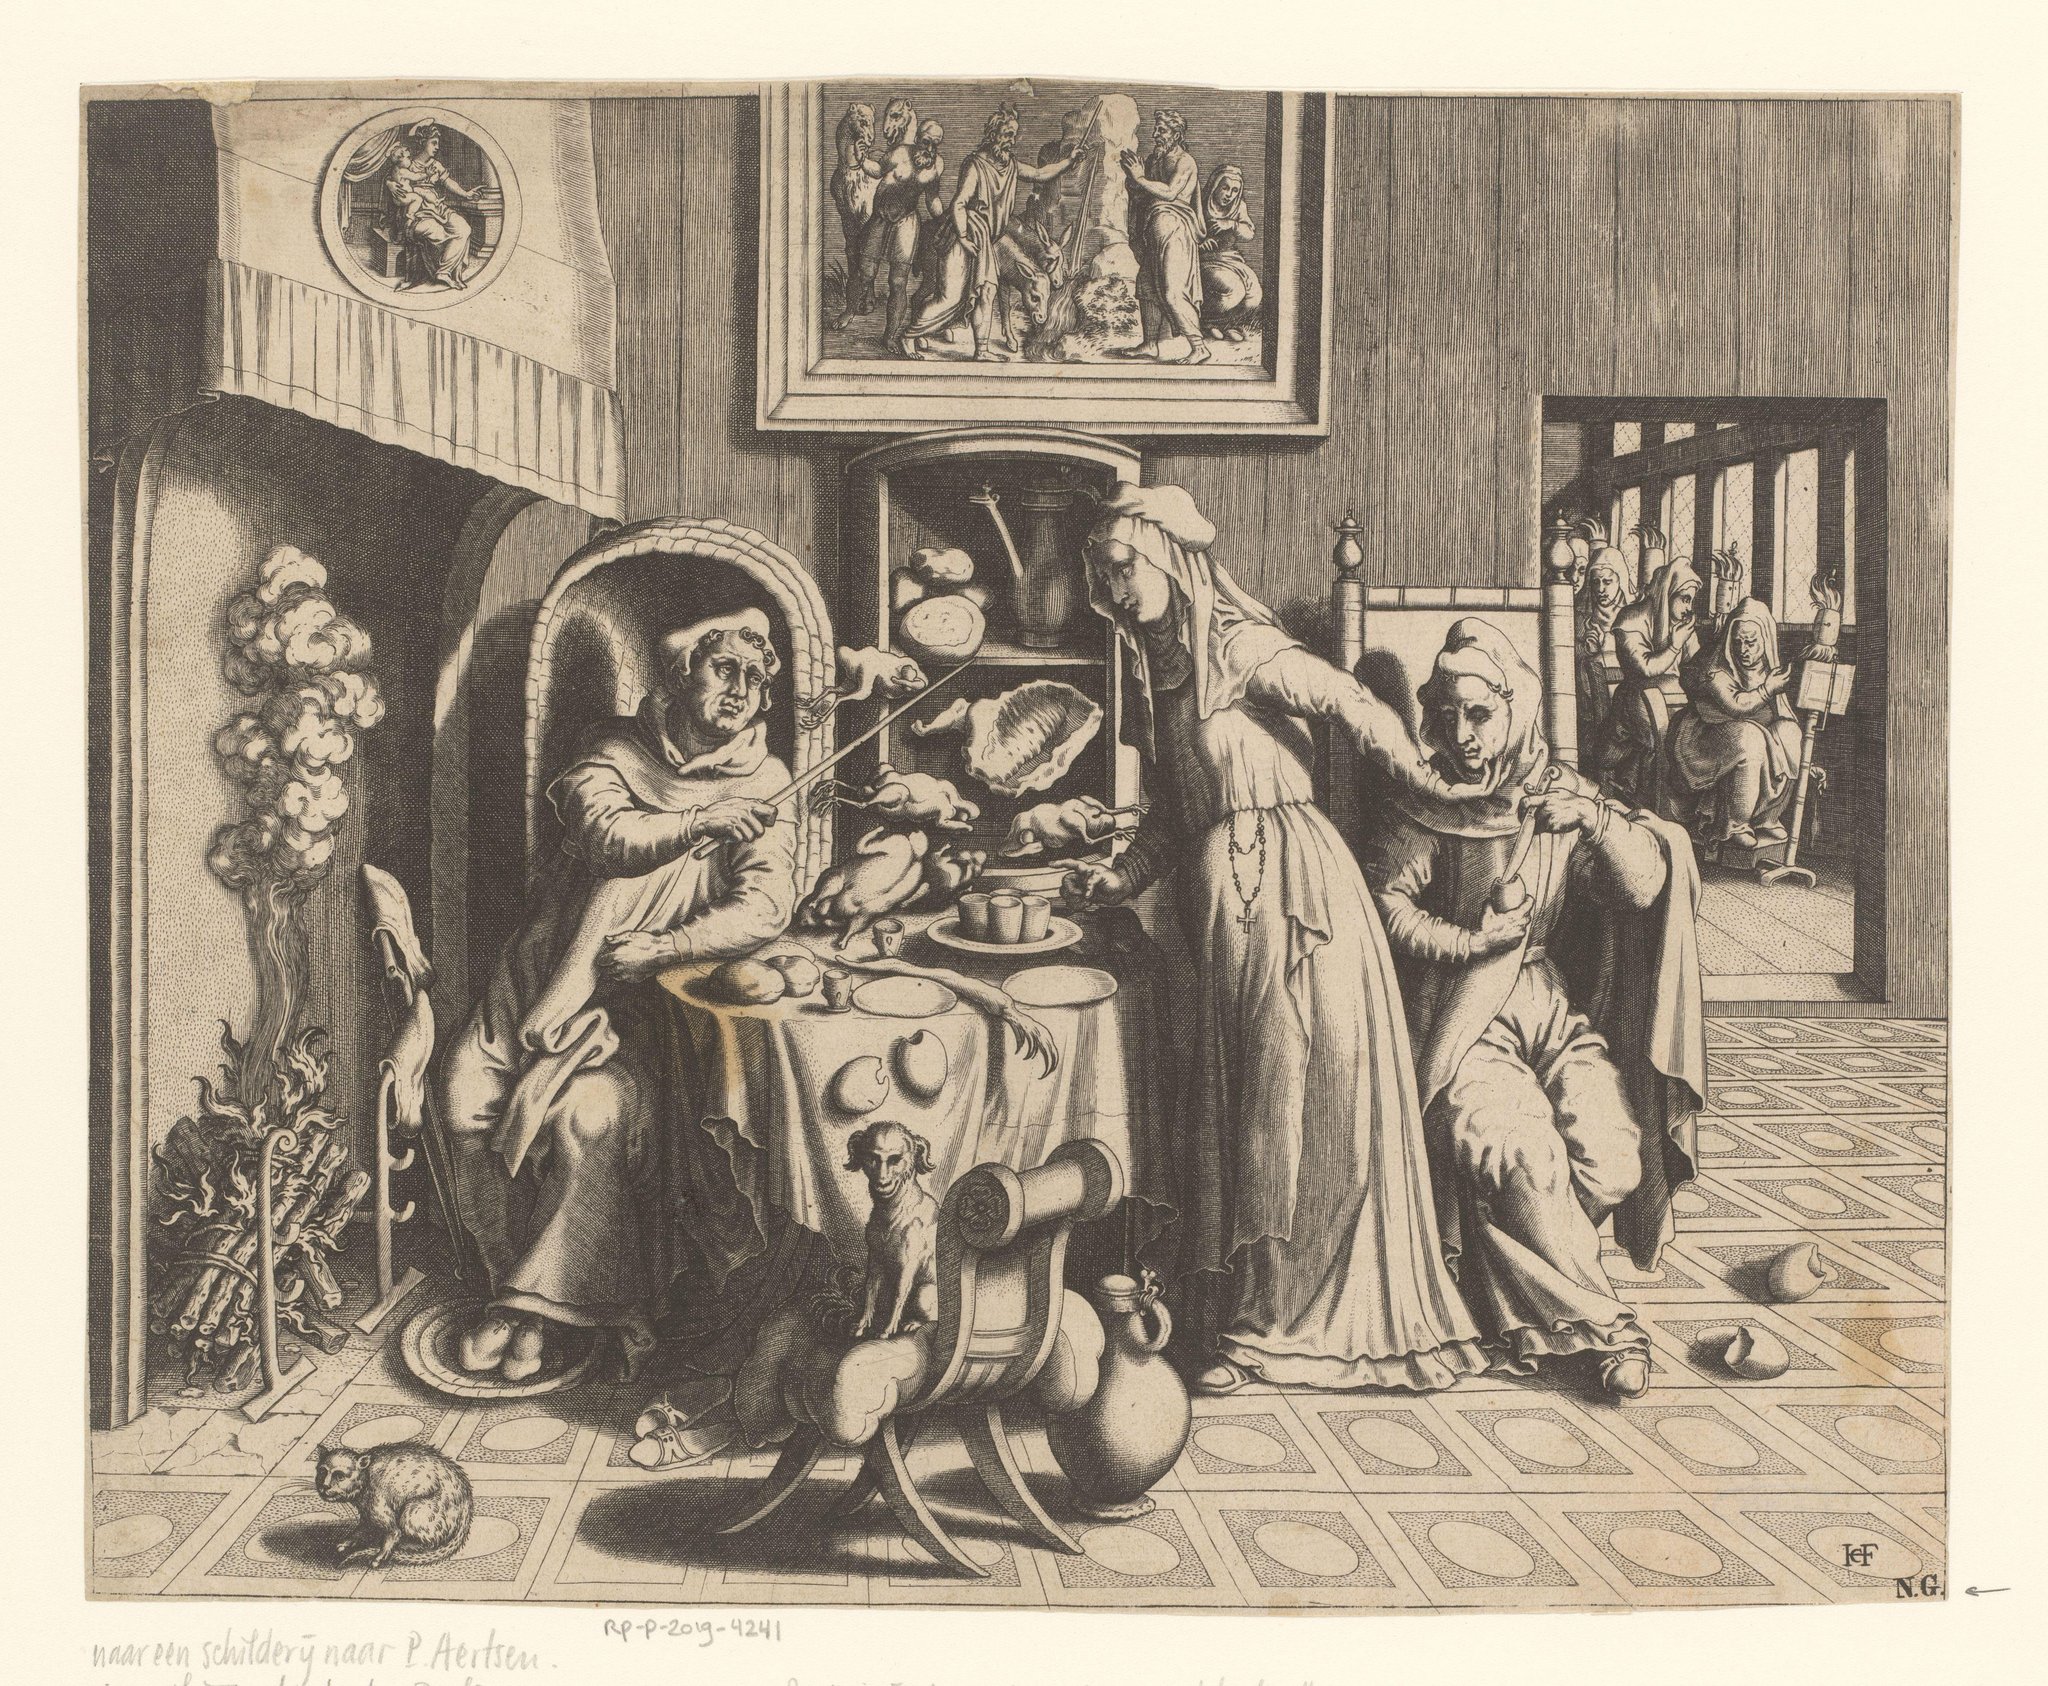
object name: print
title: Non tussen een prior en een jonge monnik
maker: pieter aertsen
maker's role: draughtsman, painter, print maker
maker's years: 1508-1575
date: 1550-1600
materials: paper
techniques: engraving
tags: monks and nuns, spinning (manufacture of yarn), laid table: table-ware, table-decoration, etc., moses striking water from the rock (exodus 17:1-7; numbers 20:2-13), hidden love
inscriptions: collector's mark: Lugt 2228, collector's mark: Lugt 1967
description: Satire op het kloosterleven, de kuisheid en matigheid. Een prior en een jonge monnik zitten aan een gedekte tafel vol eten voor een haardvuur. Voor de prior staat een jonge non, die door hem terechtgewezen wordt. Achter haar rug streelt de non het gezicht van de jonge monnik. De haard is versierd met een medaillon waarop Maria met het Christuskind. Achter het gezelschap hangt een voorstelling van Mozes die water uit de rots slaat voor de Israëlieten. Rechtsachter zitten nonnen te spinnen.